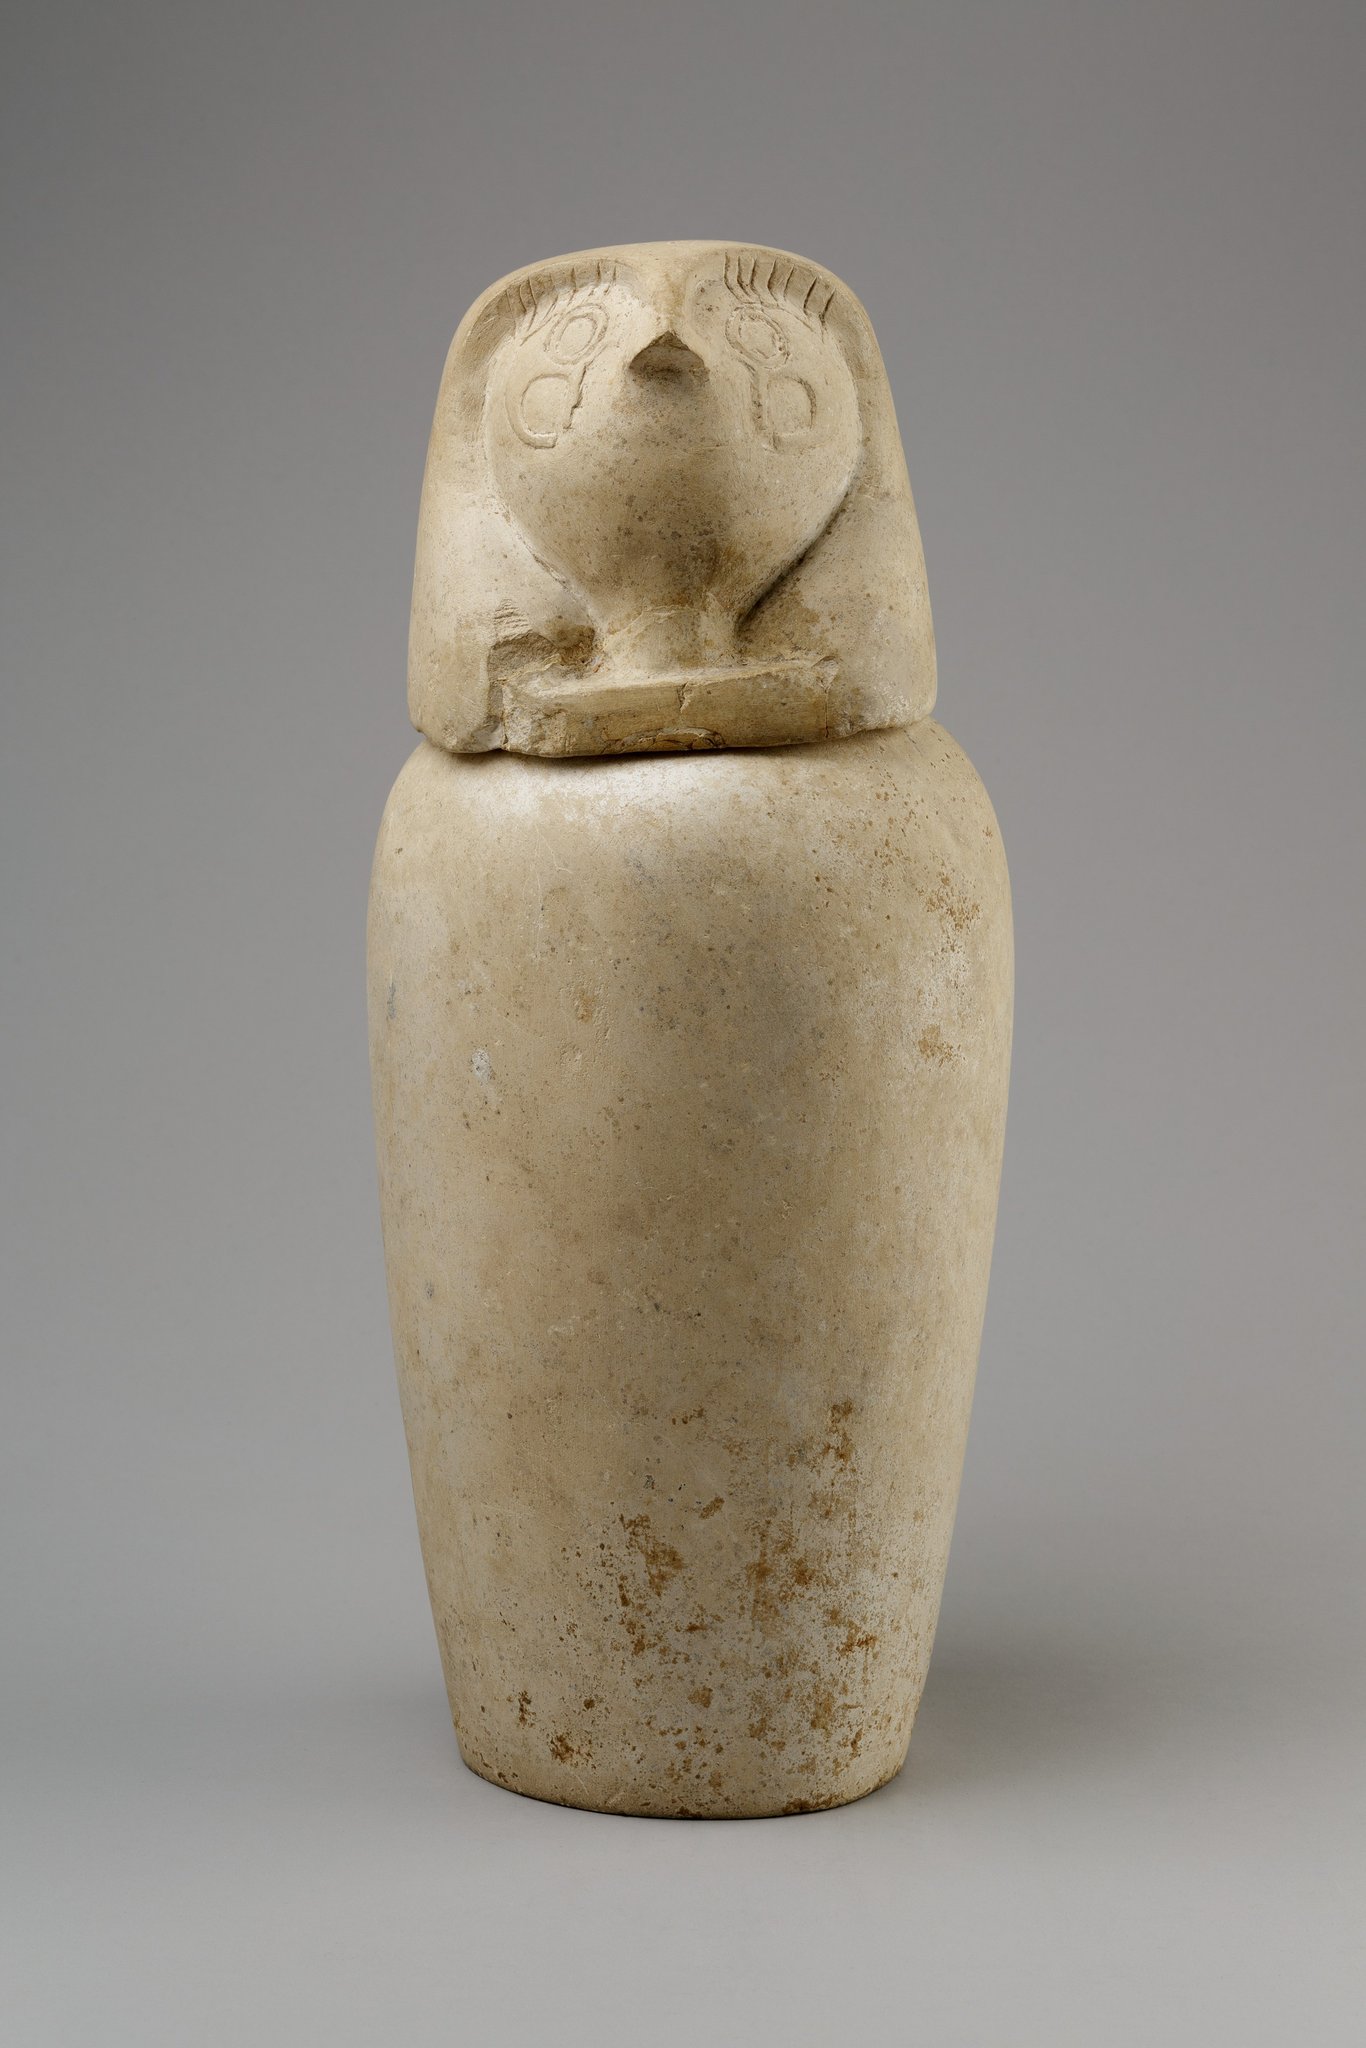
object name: canopic jar with falcon head qebehsenuef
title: Canopic jar with falcon head (Qebehsenuef)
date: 800-650 BCE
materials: limestone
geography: egypt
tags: falcons